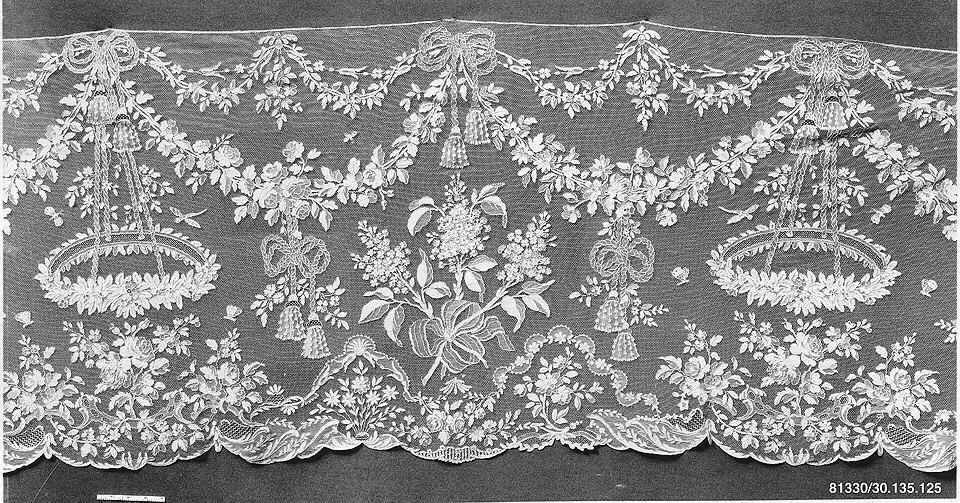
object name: flounce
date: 1801-1900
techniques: lace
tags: flowers